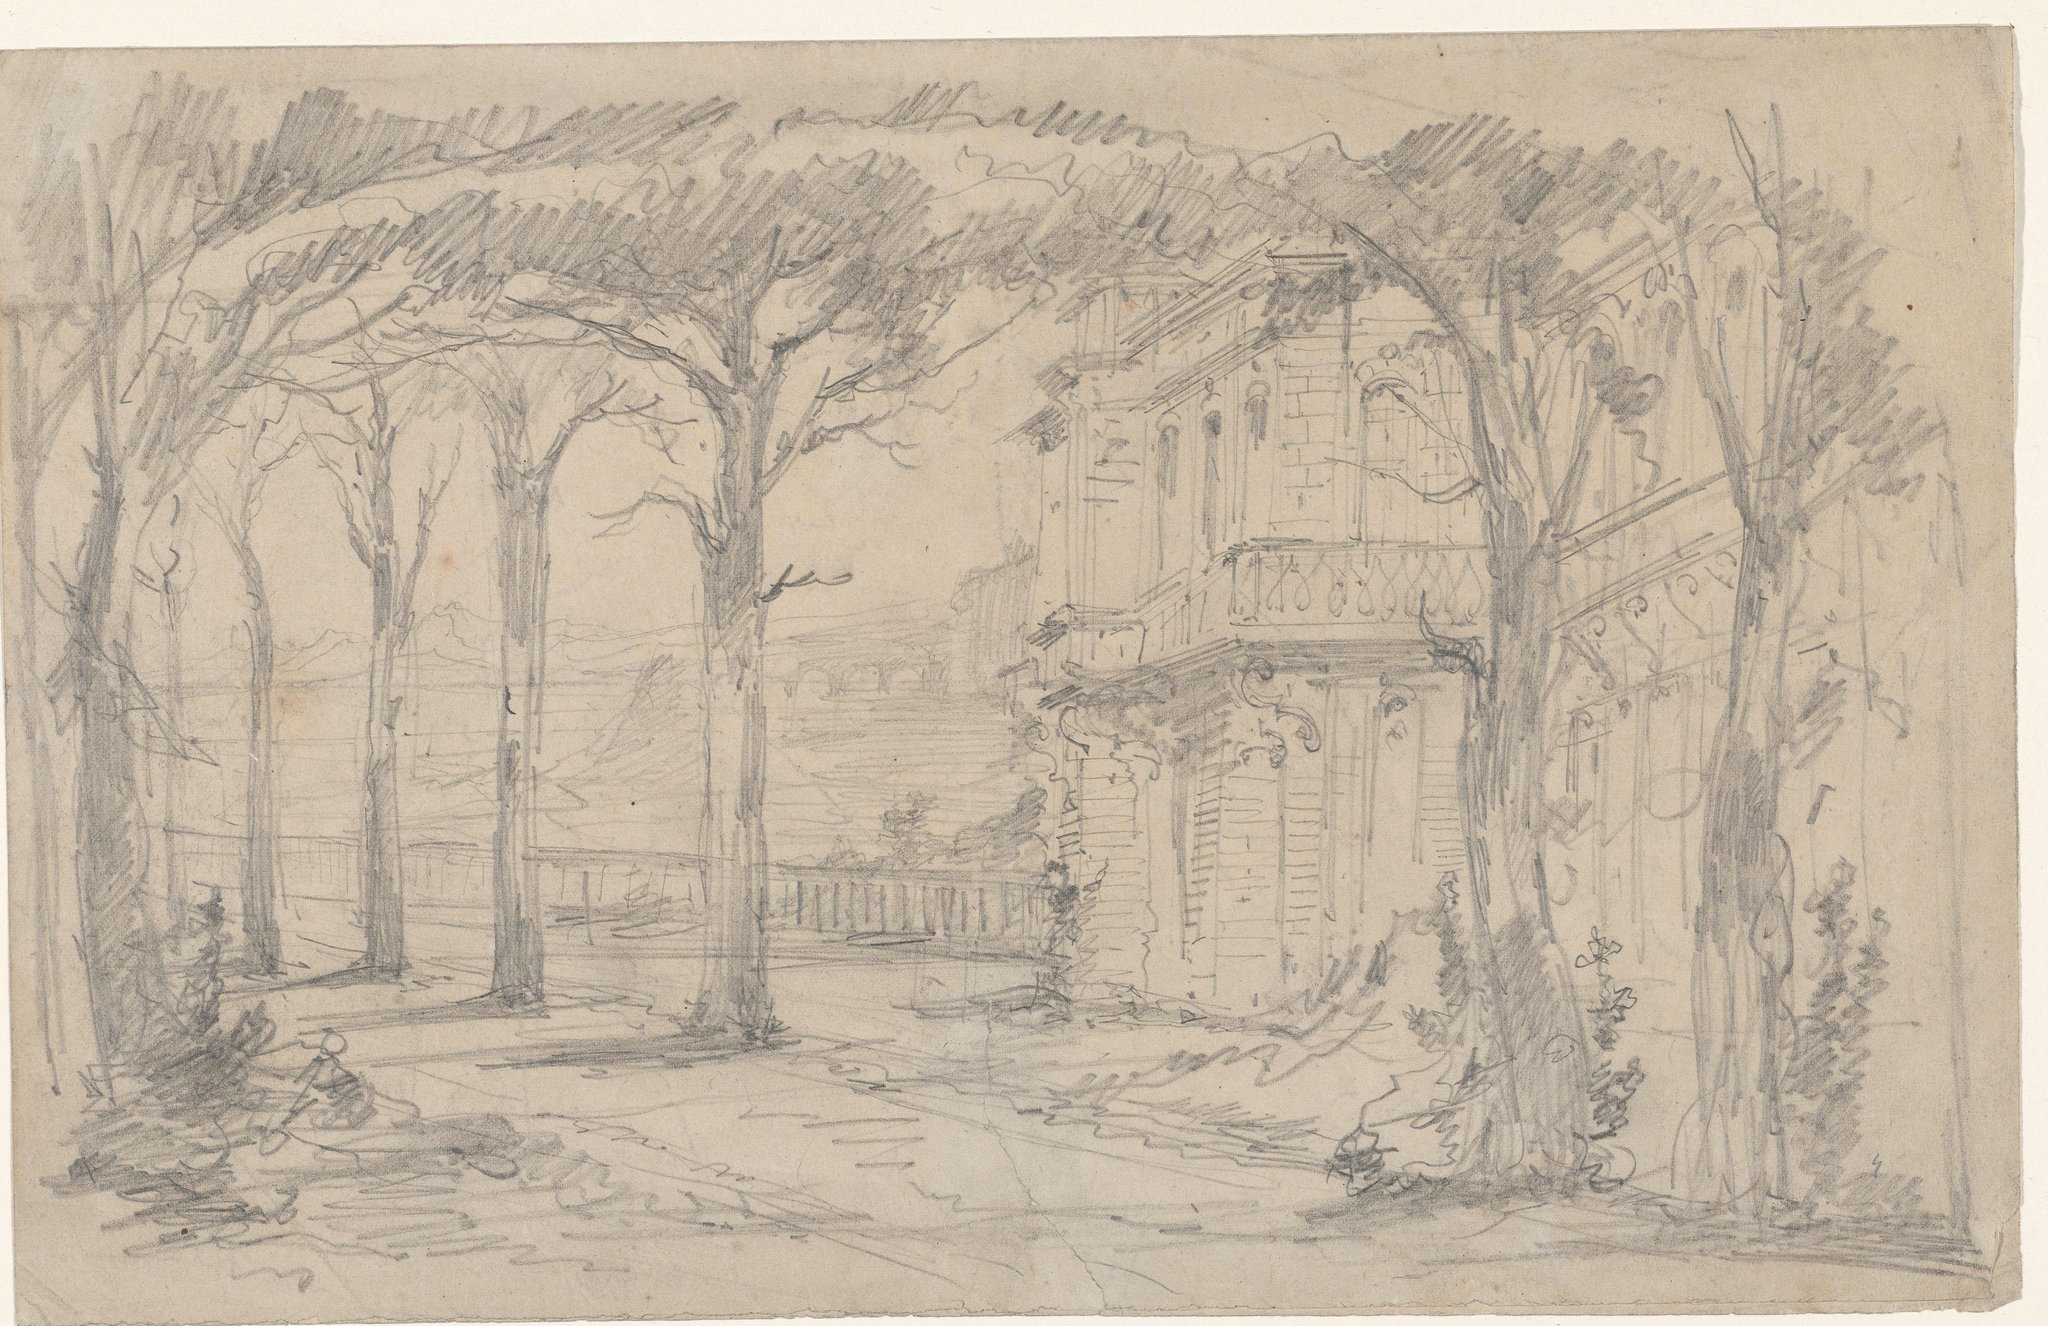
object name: drawing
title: Huis achter een laan met bomen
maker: maxime françois antoine lalanne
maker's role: draughtsman, print maker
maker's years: 1827-1886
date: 1837-1886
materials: paper, pencil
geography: france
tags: villa